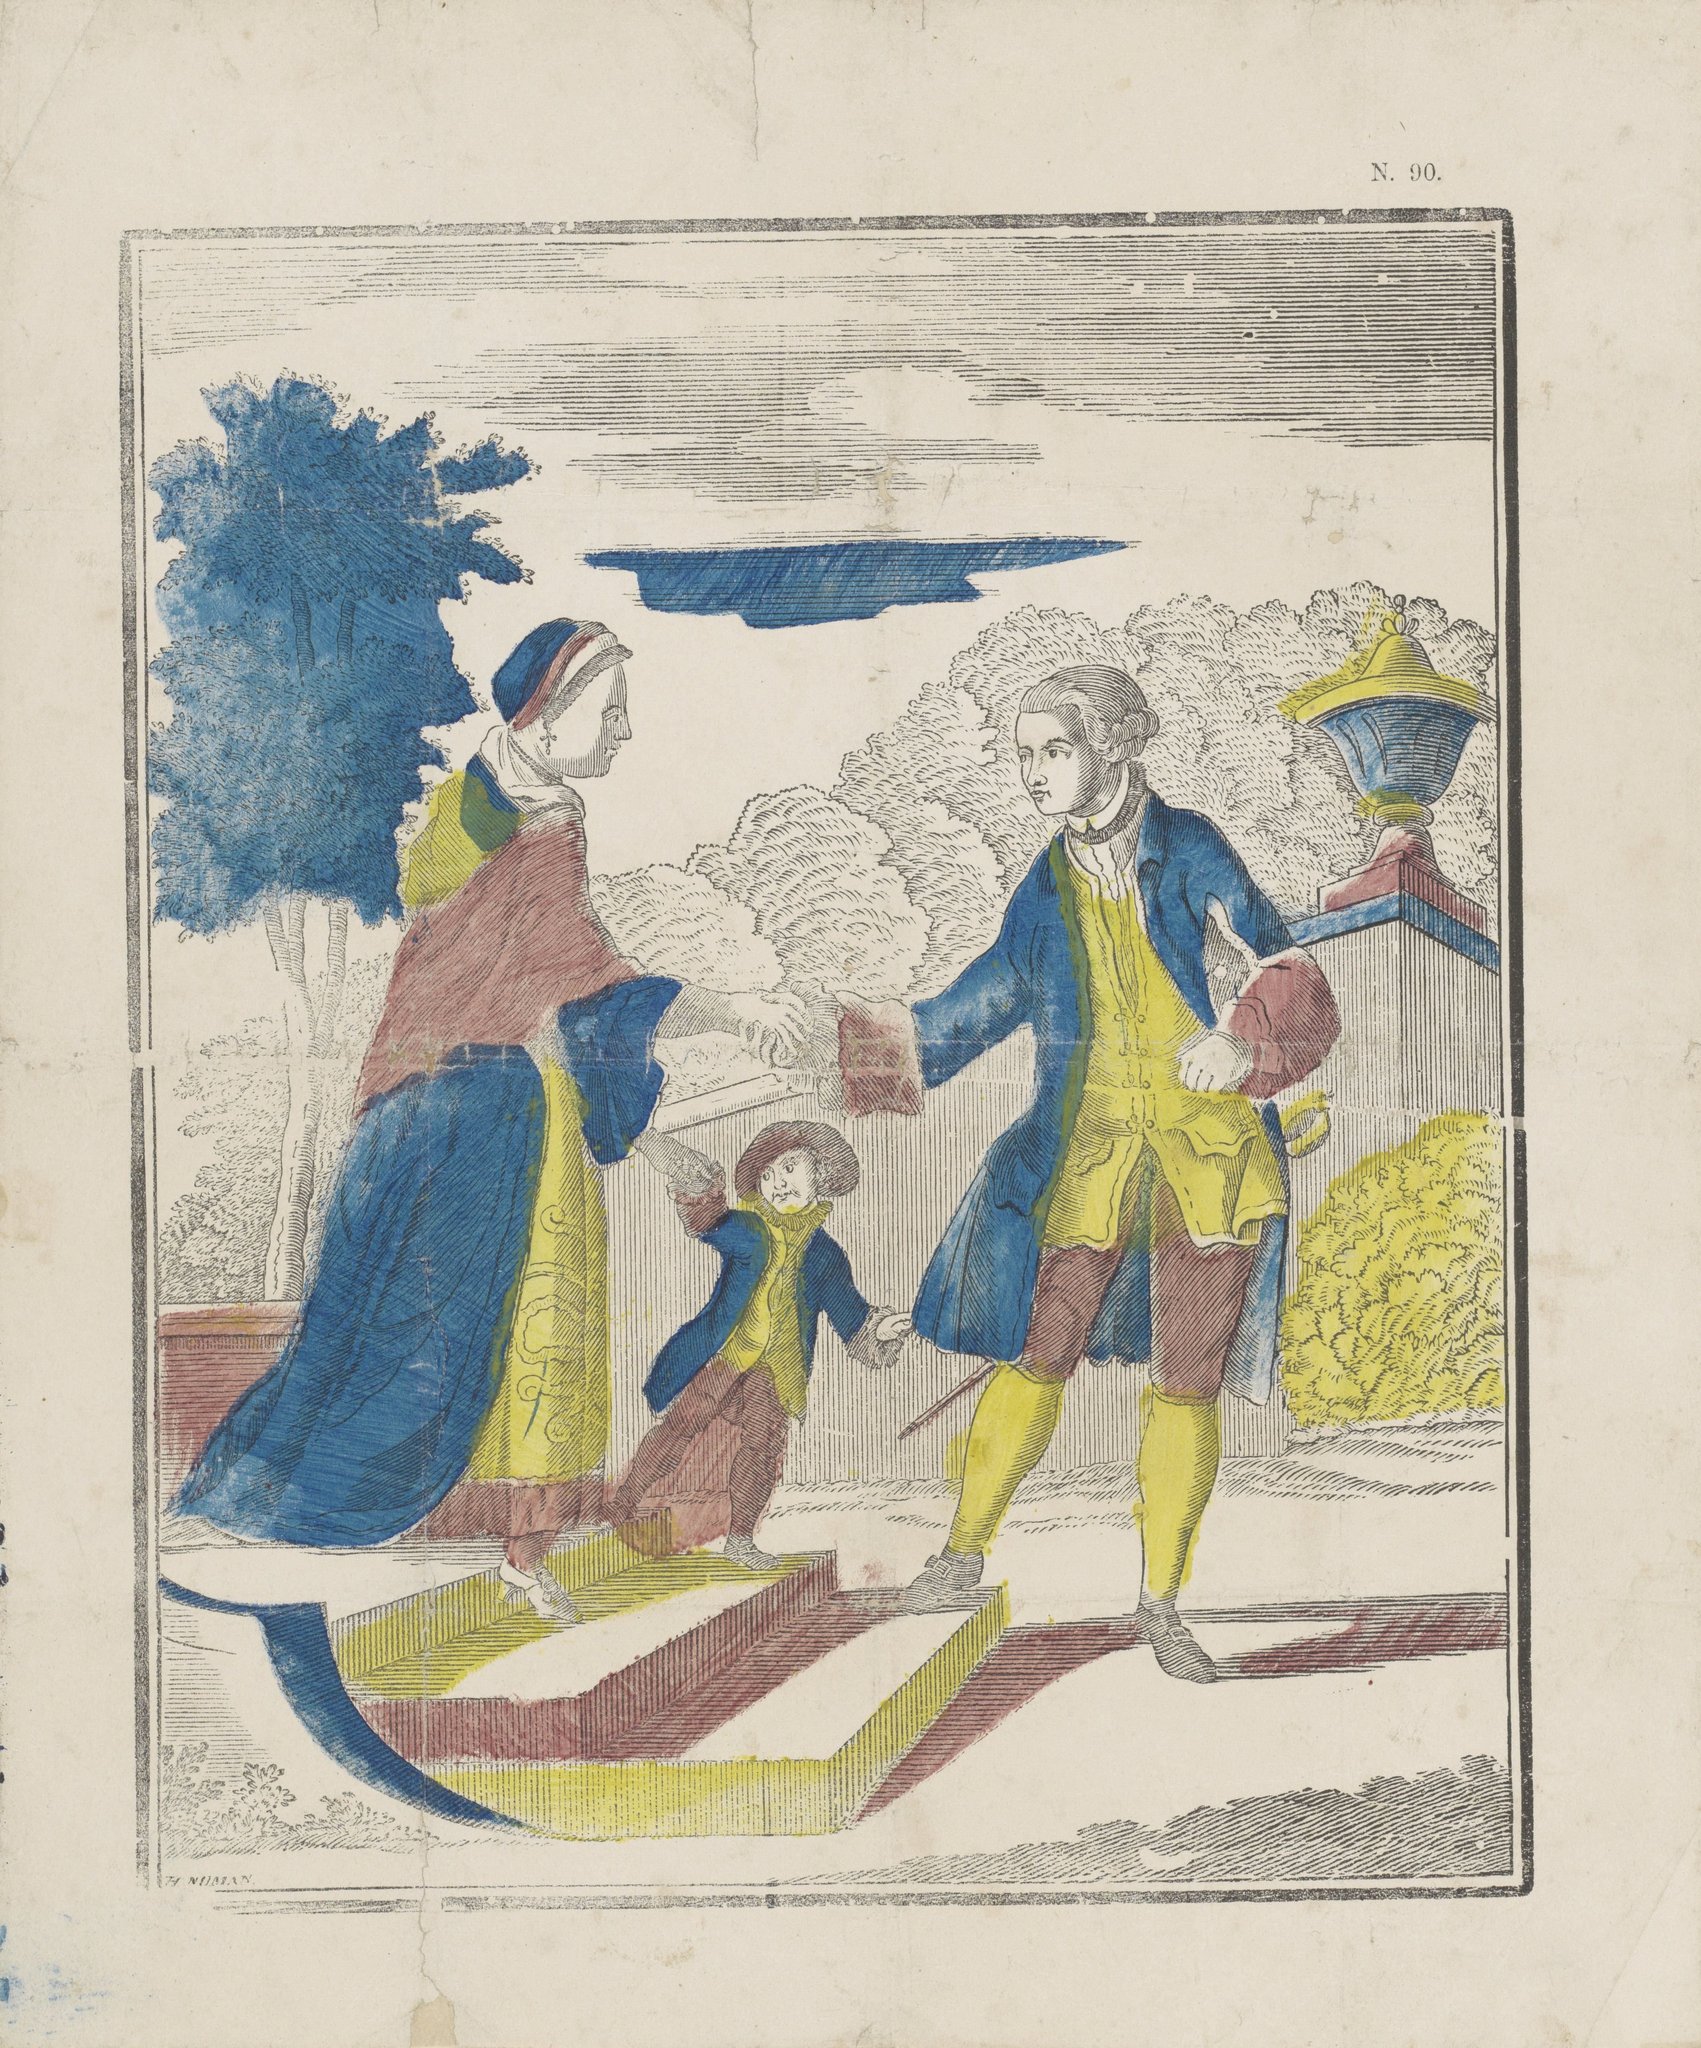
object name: print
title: Heer neemt afscheid van vrouw en kind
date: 1848-1881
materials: paper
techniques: colour, letterpress printing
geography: den bosch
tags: family group, especially parents with their child(ren)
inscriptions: collector's mark: Lugt 2760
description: Blad met grote voorstelling van een man die afscheid neemt van zijn vrouw en zoon. Genummerd rechtsboven: N. 90.